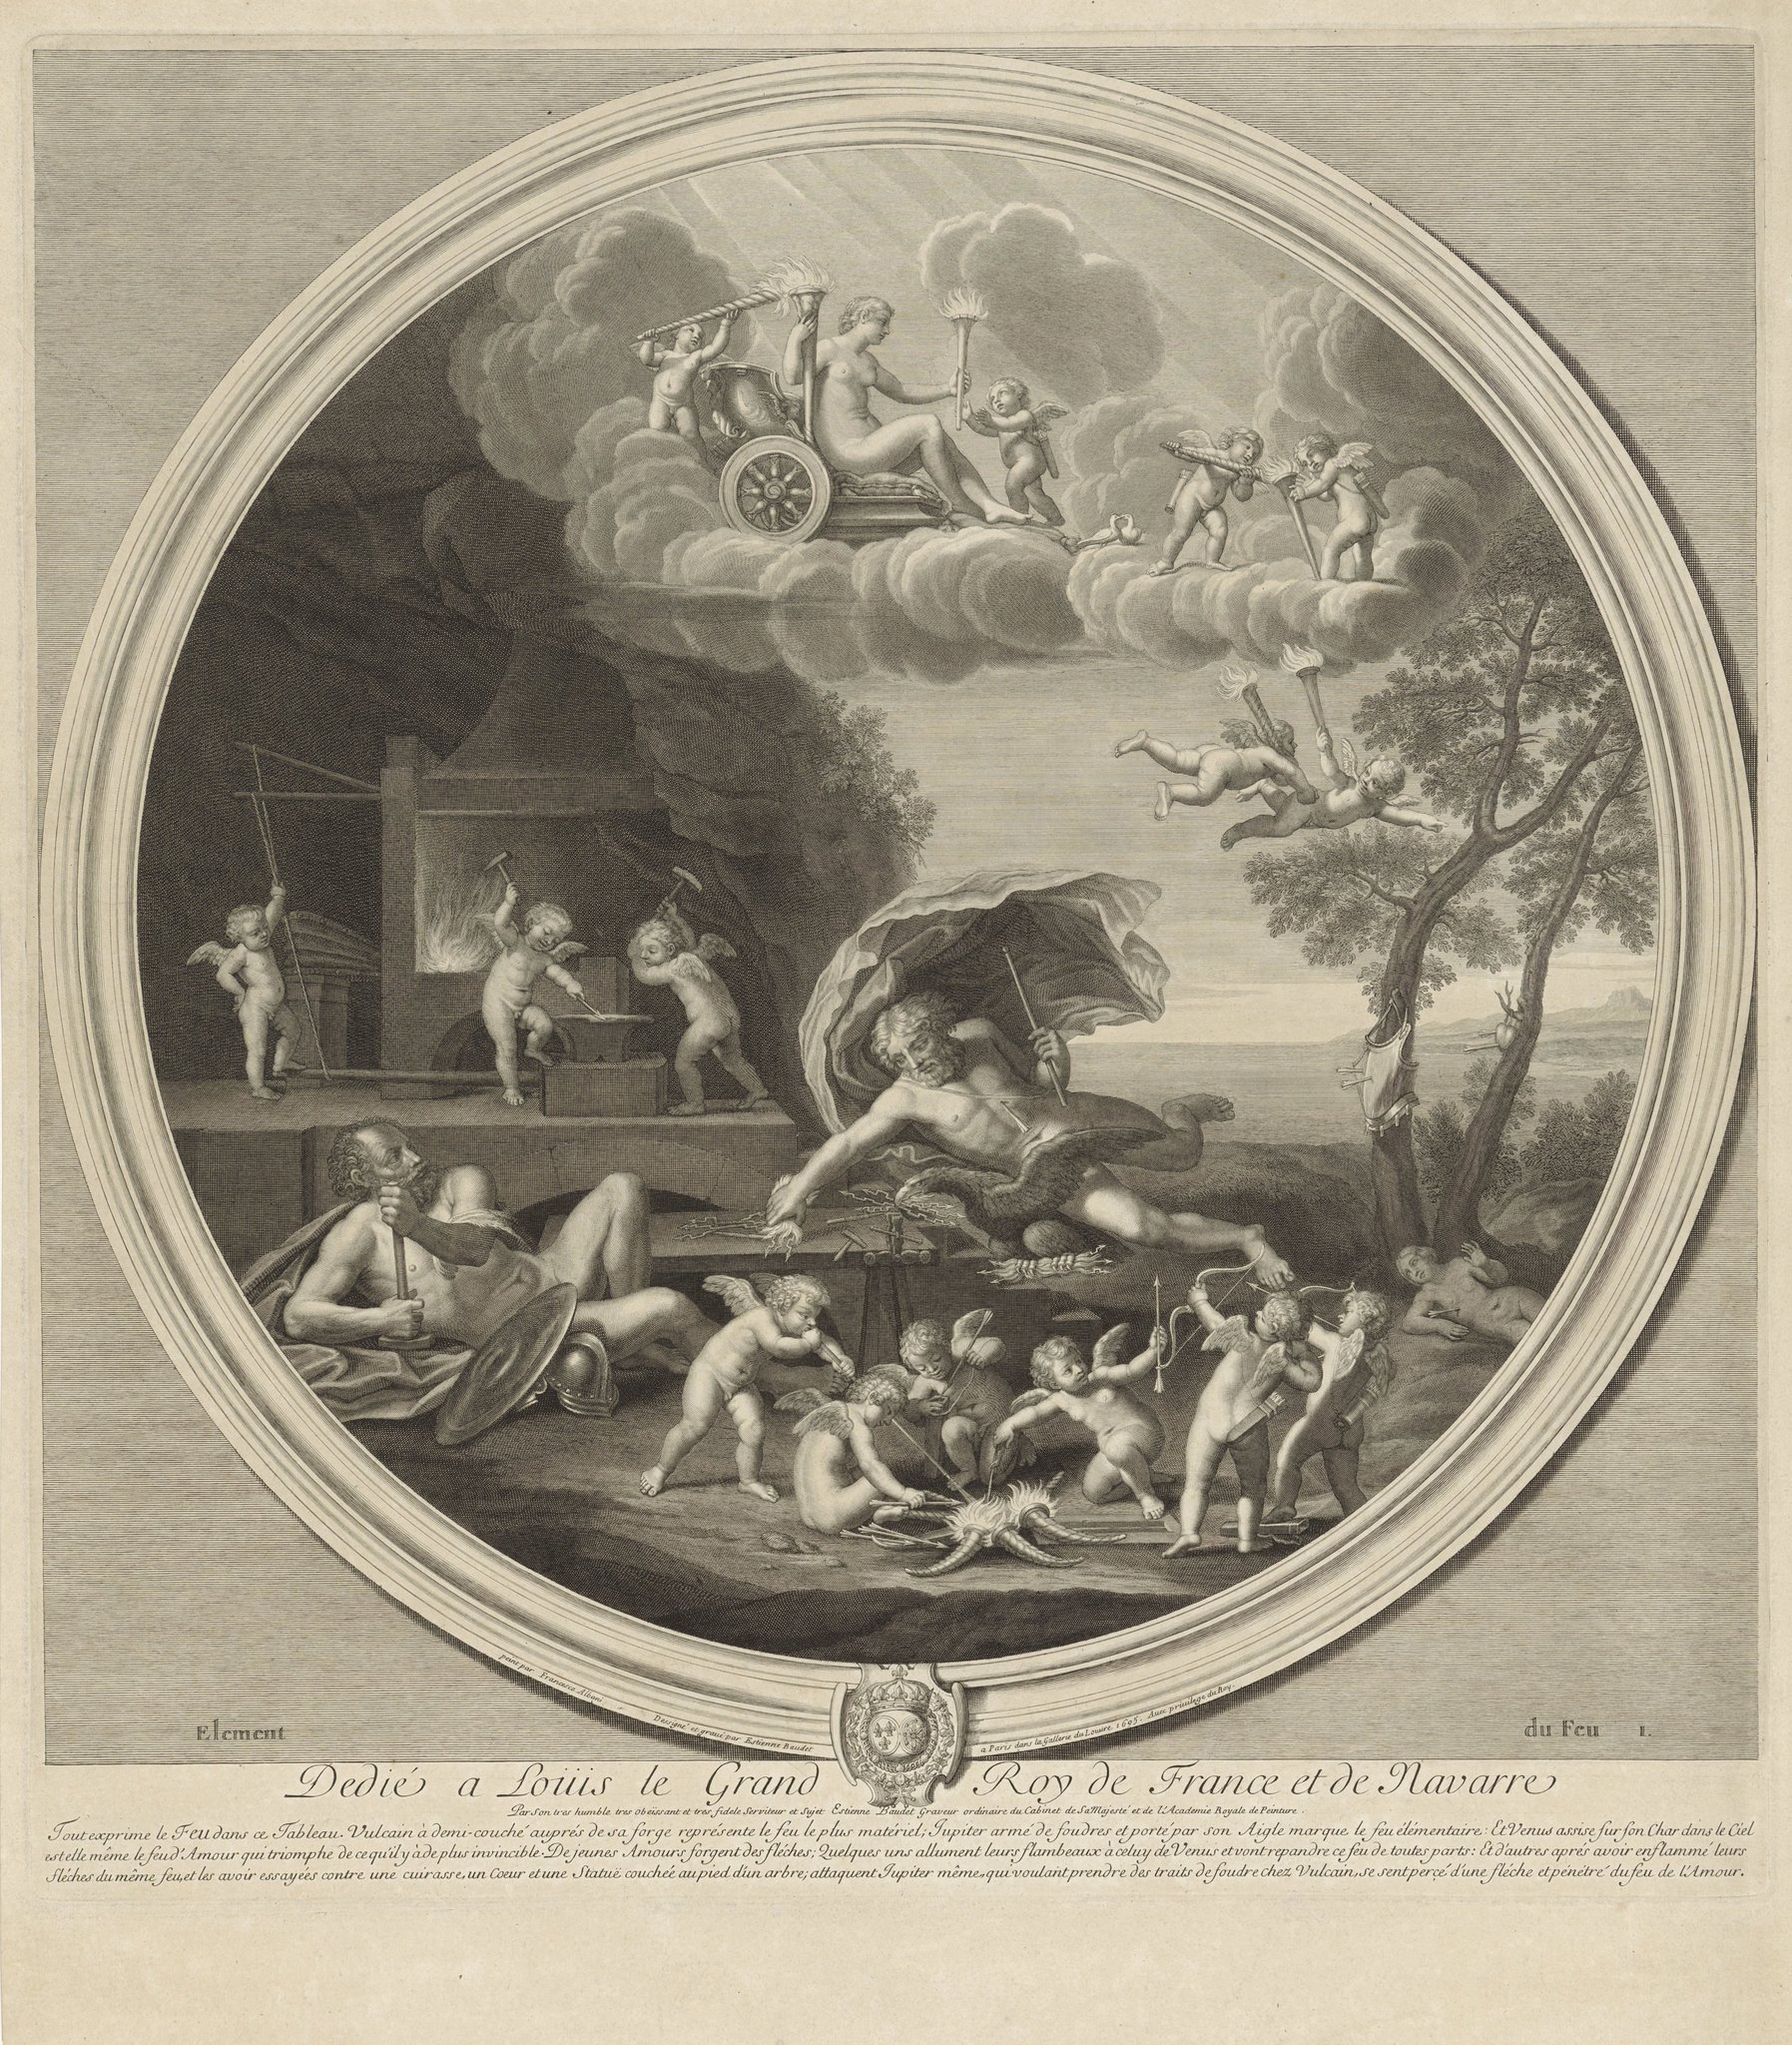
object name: print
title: Element Vuur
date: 1695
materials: paper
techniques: engraving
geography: france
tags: fire (one of the four elements), 'fuoco', 'carro del fuoco' (ripa), forging (industrial process), armorial bearing, heraldry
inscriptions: collector's mark: Lugt 2228